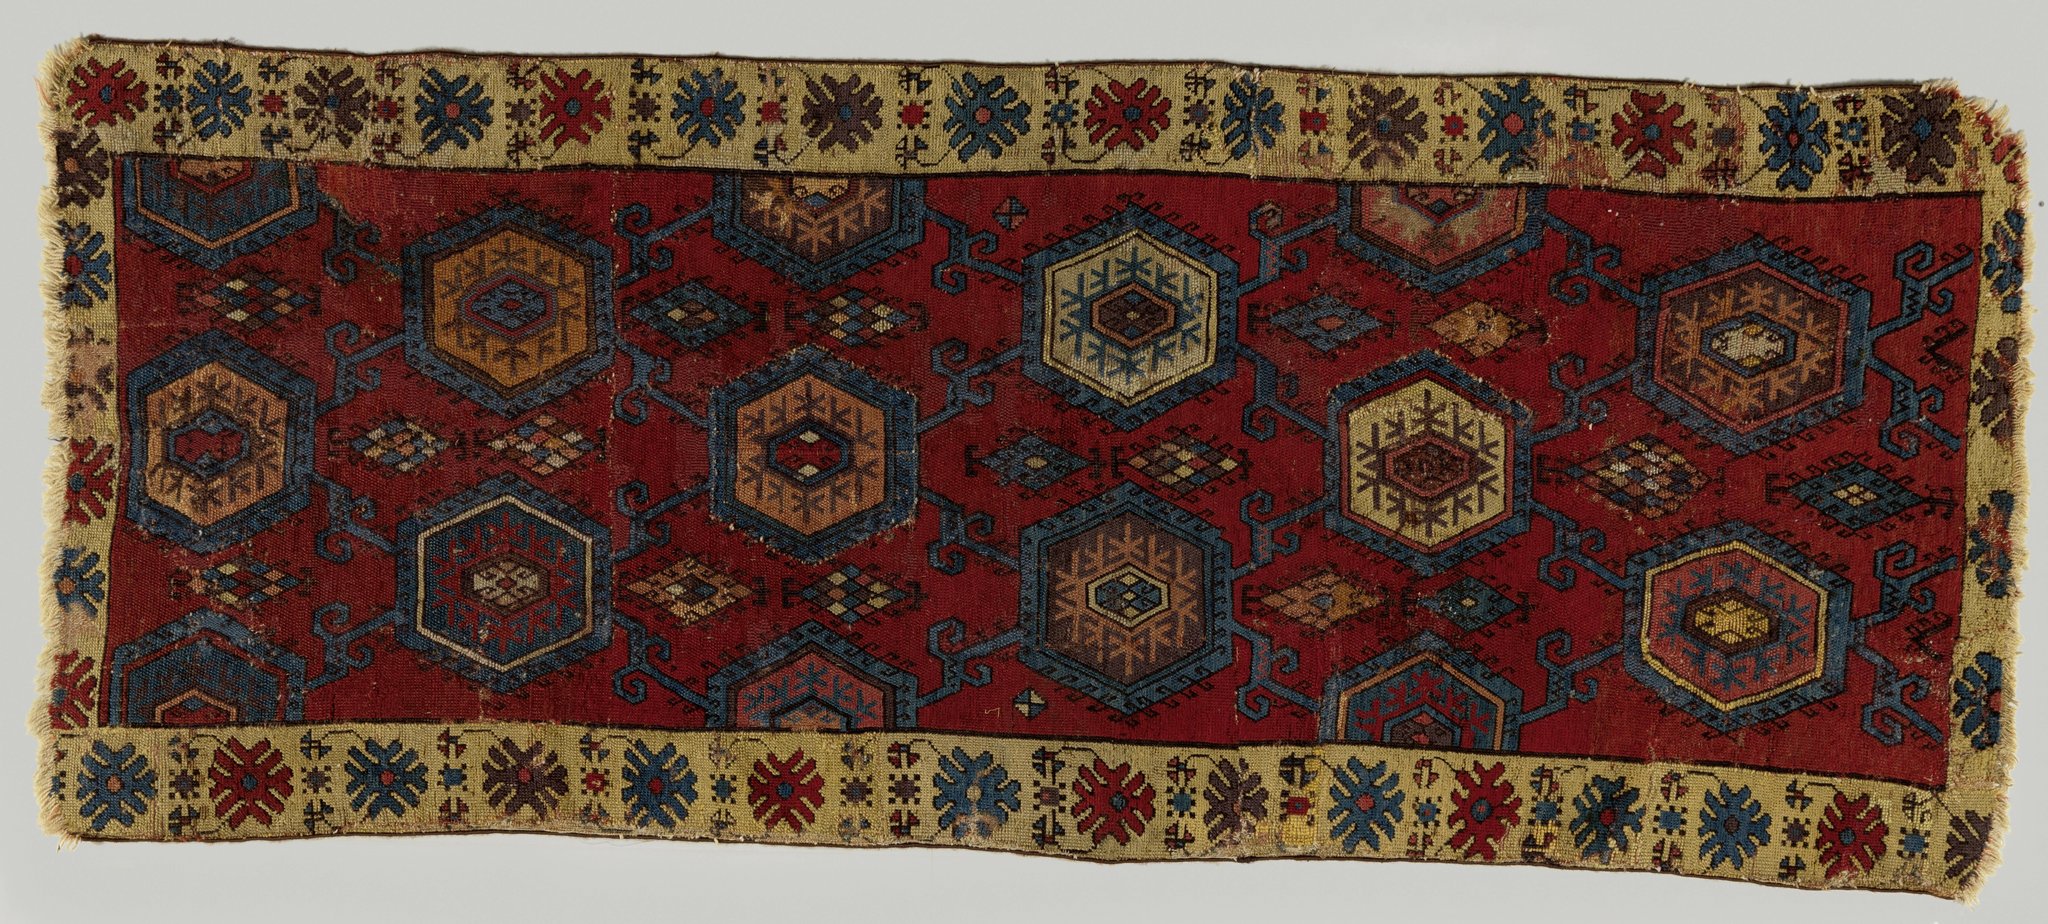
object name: oriental rug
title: Oosters tapijt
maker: Anonymous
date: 1685-1700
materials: wool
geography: caucasus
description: Oosters tapijt, medaillonkleed. In het middenveld staan zeshoekige medaillons, verbonden door ranken tegen een bruinrood fond. Voorts gestrooide ruiten. De rand is versierd met rozetten.